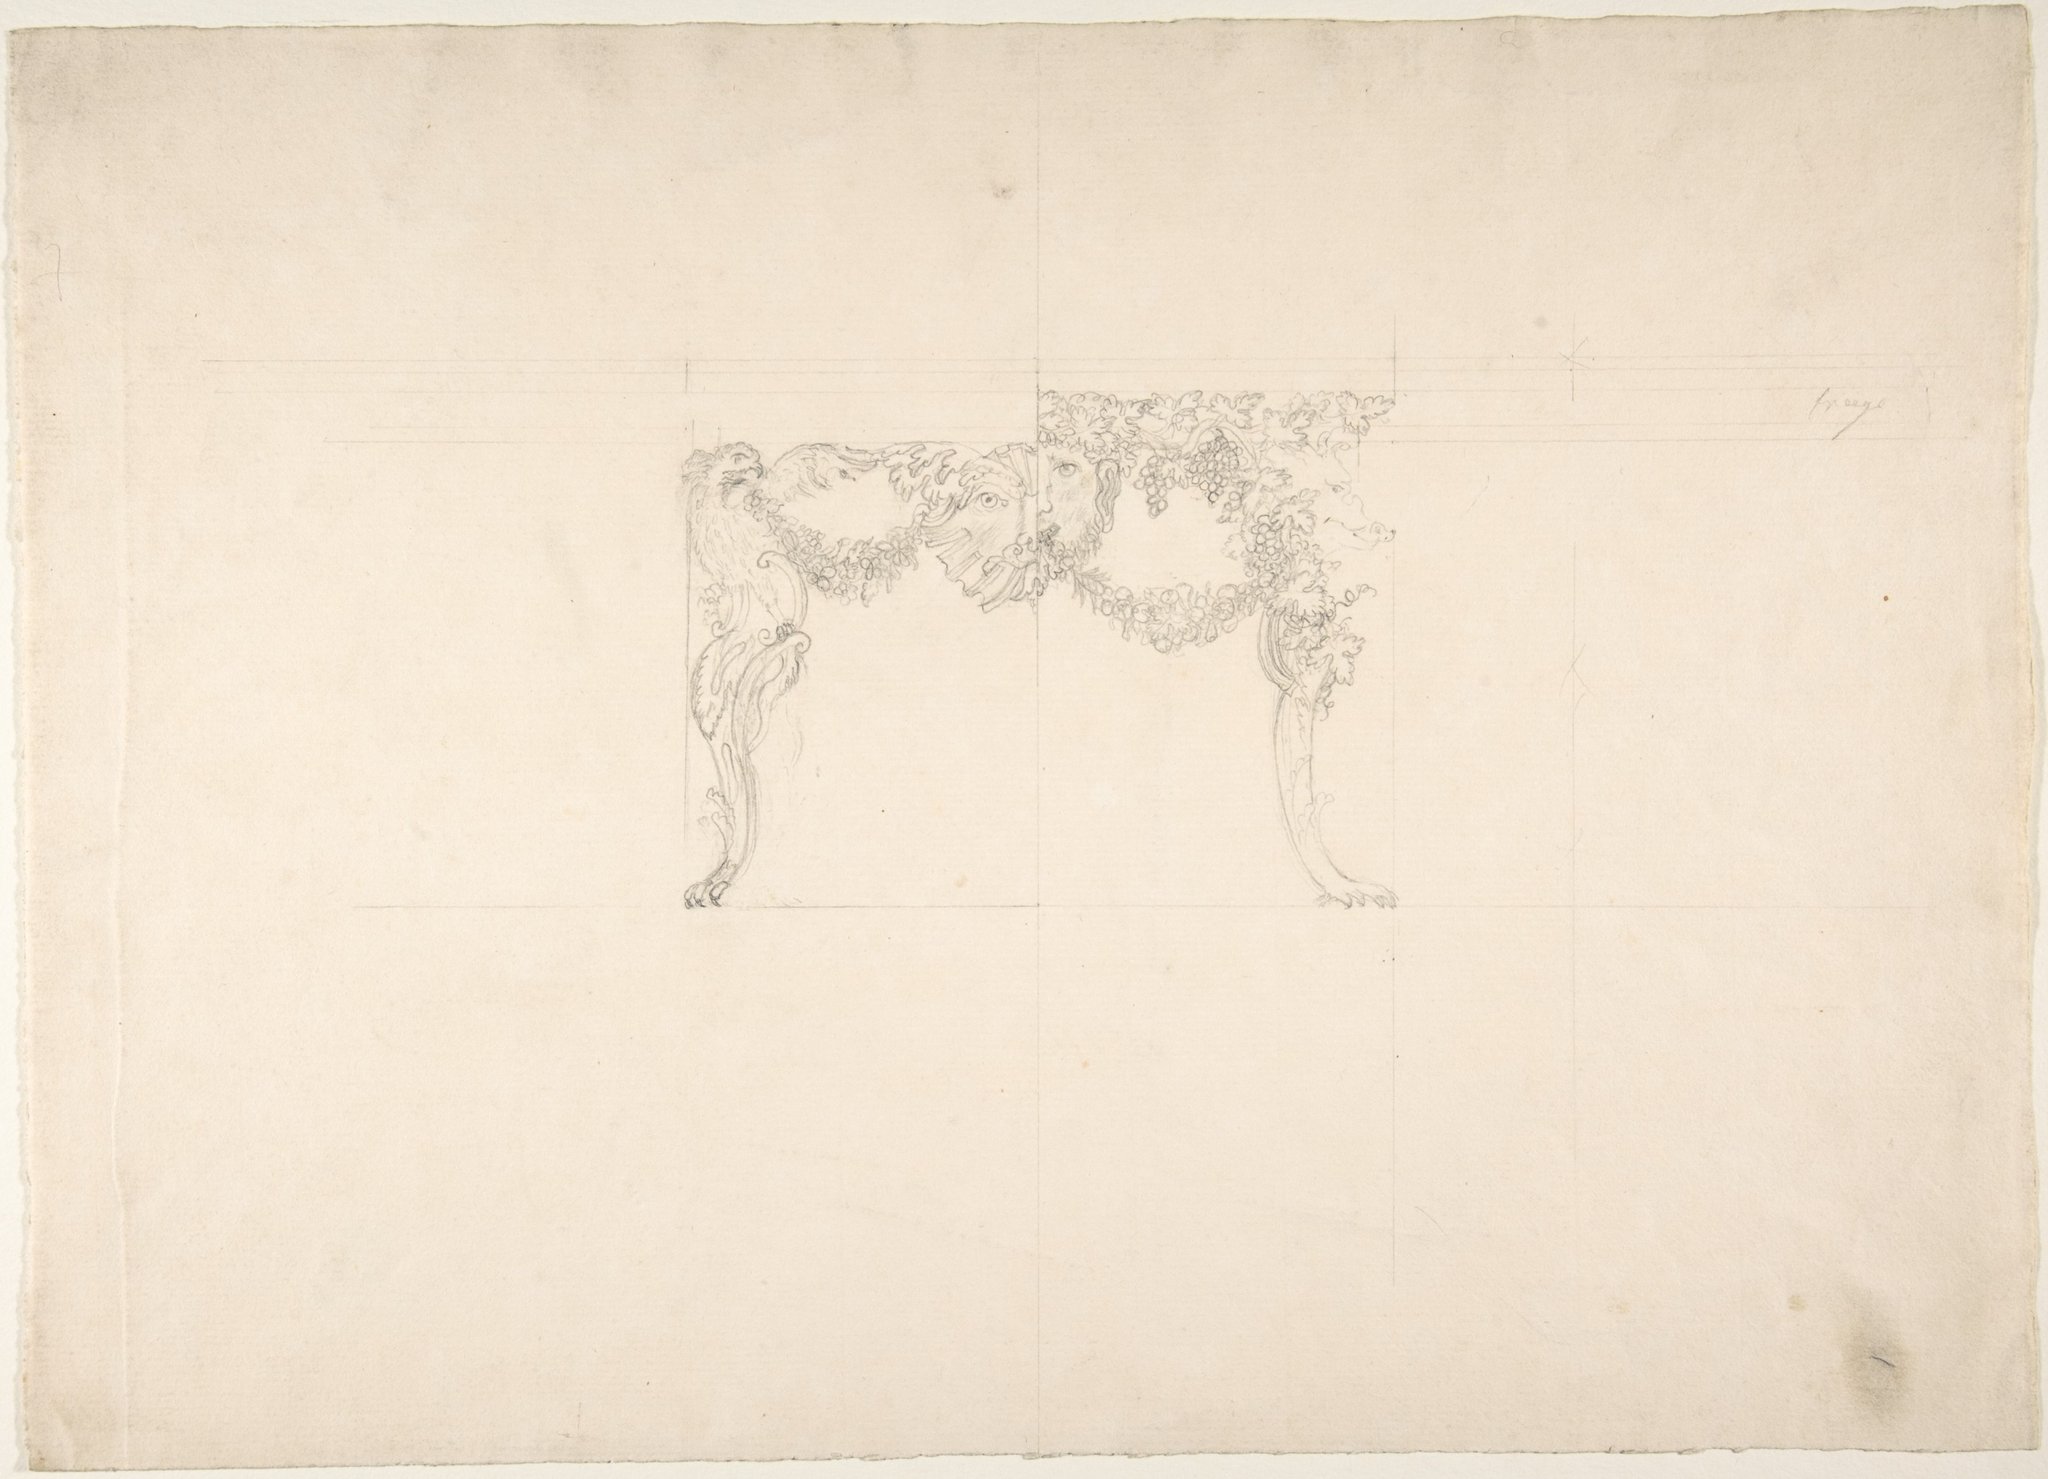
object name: drawing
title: Table Design with Bacchus and Boar's Head, and Alternate Design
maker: anonymous, british, 19th century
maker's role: artist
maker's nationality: british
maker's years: 1800-1900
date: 1801-1900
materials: graphite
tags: bacchus,boars